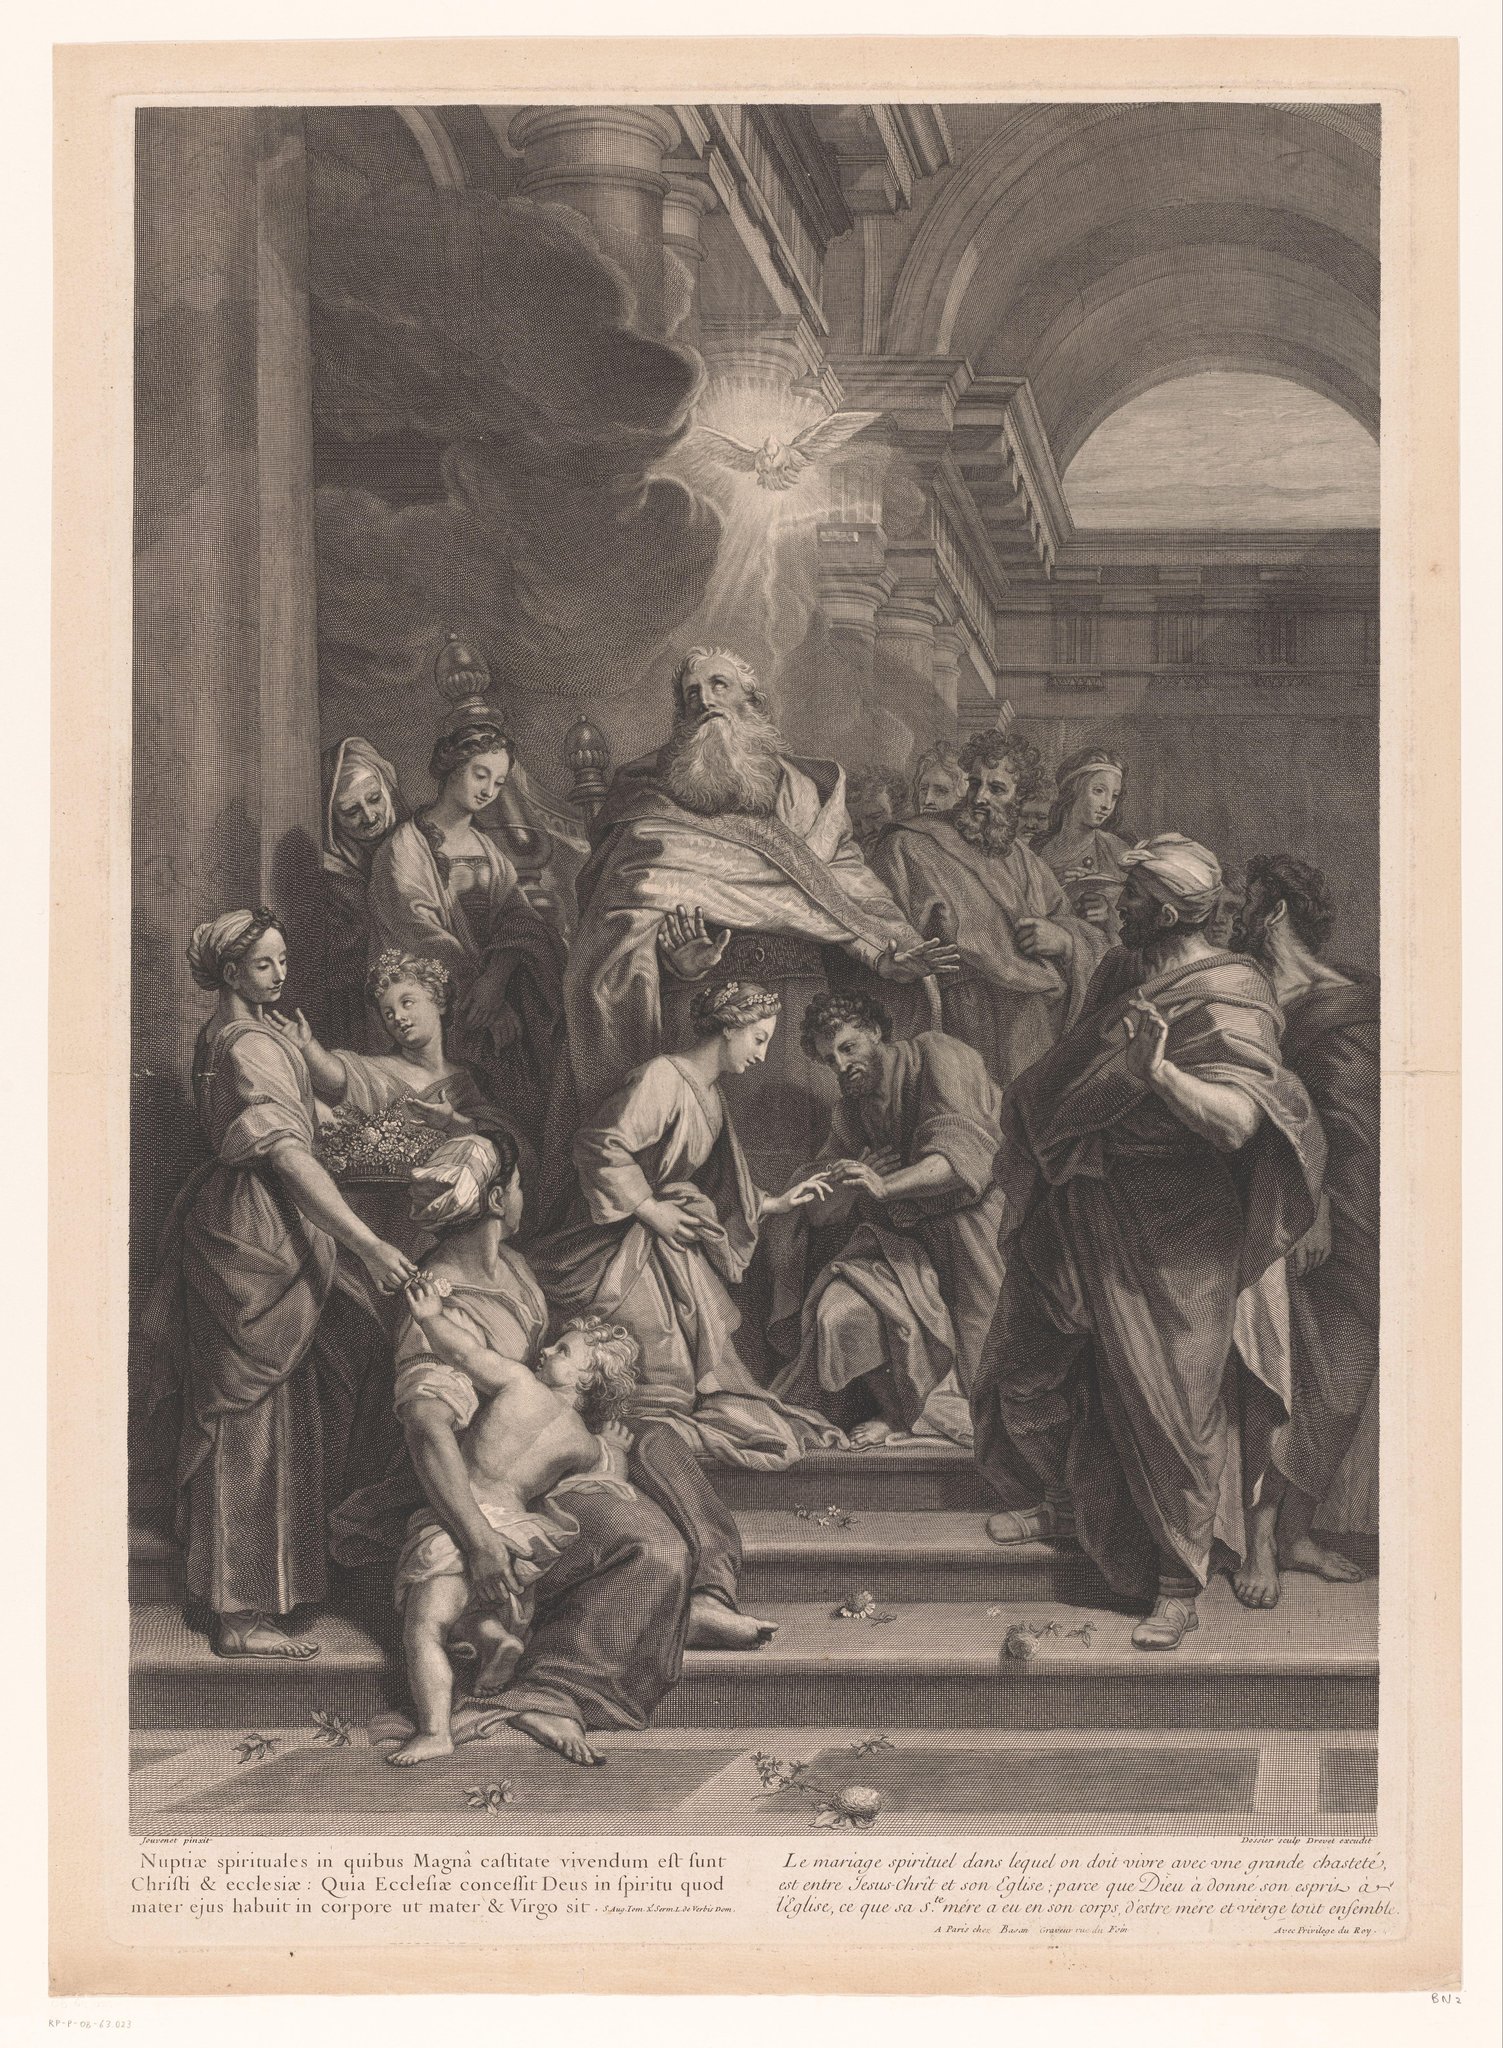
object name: print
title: Huwelijk van Maria en Jozef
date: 1694-1738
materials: paper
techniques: engraving, etching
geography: france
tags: mary and joseph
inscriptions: collector's mark: Lugt 2228, watermark